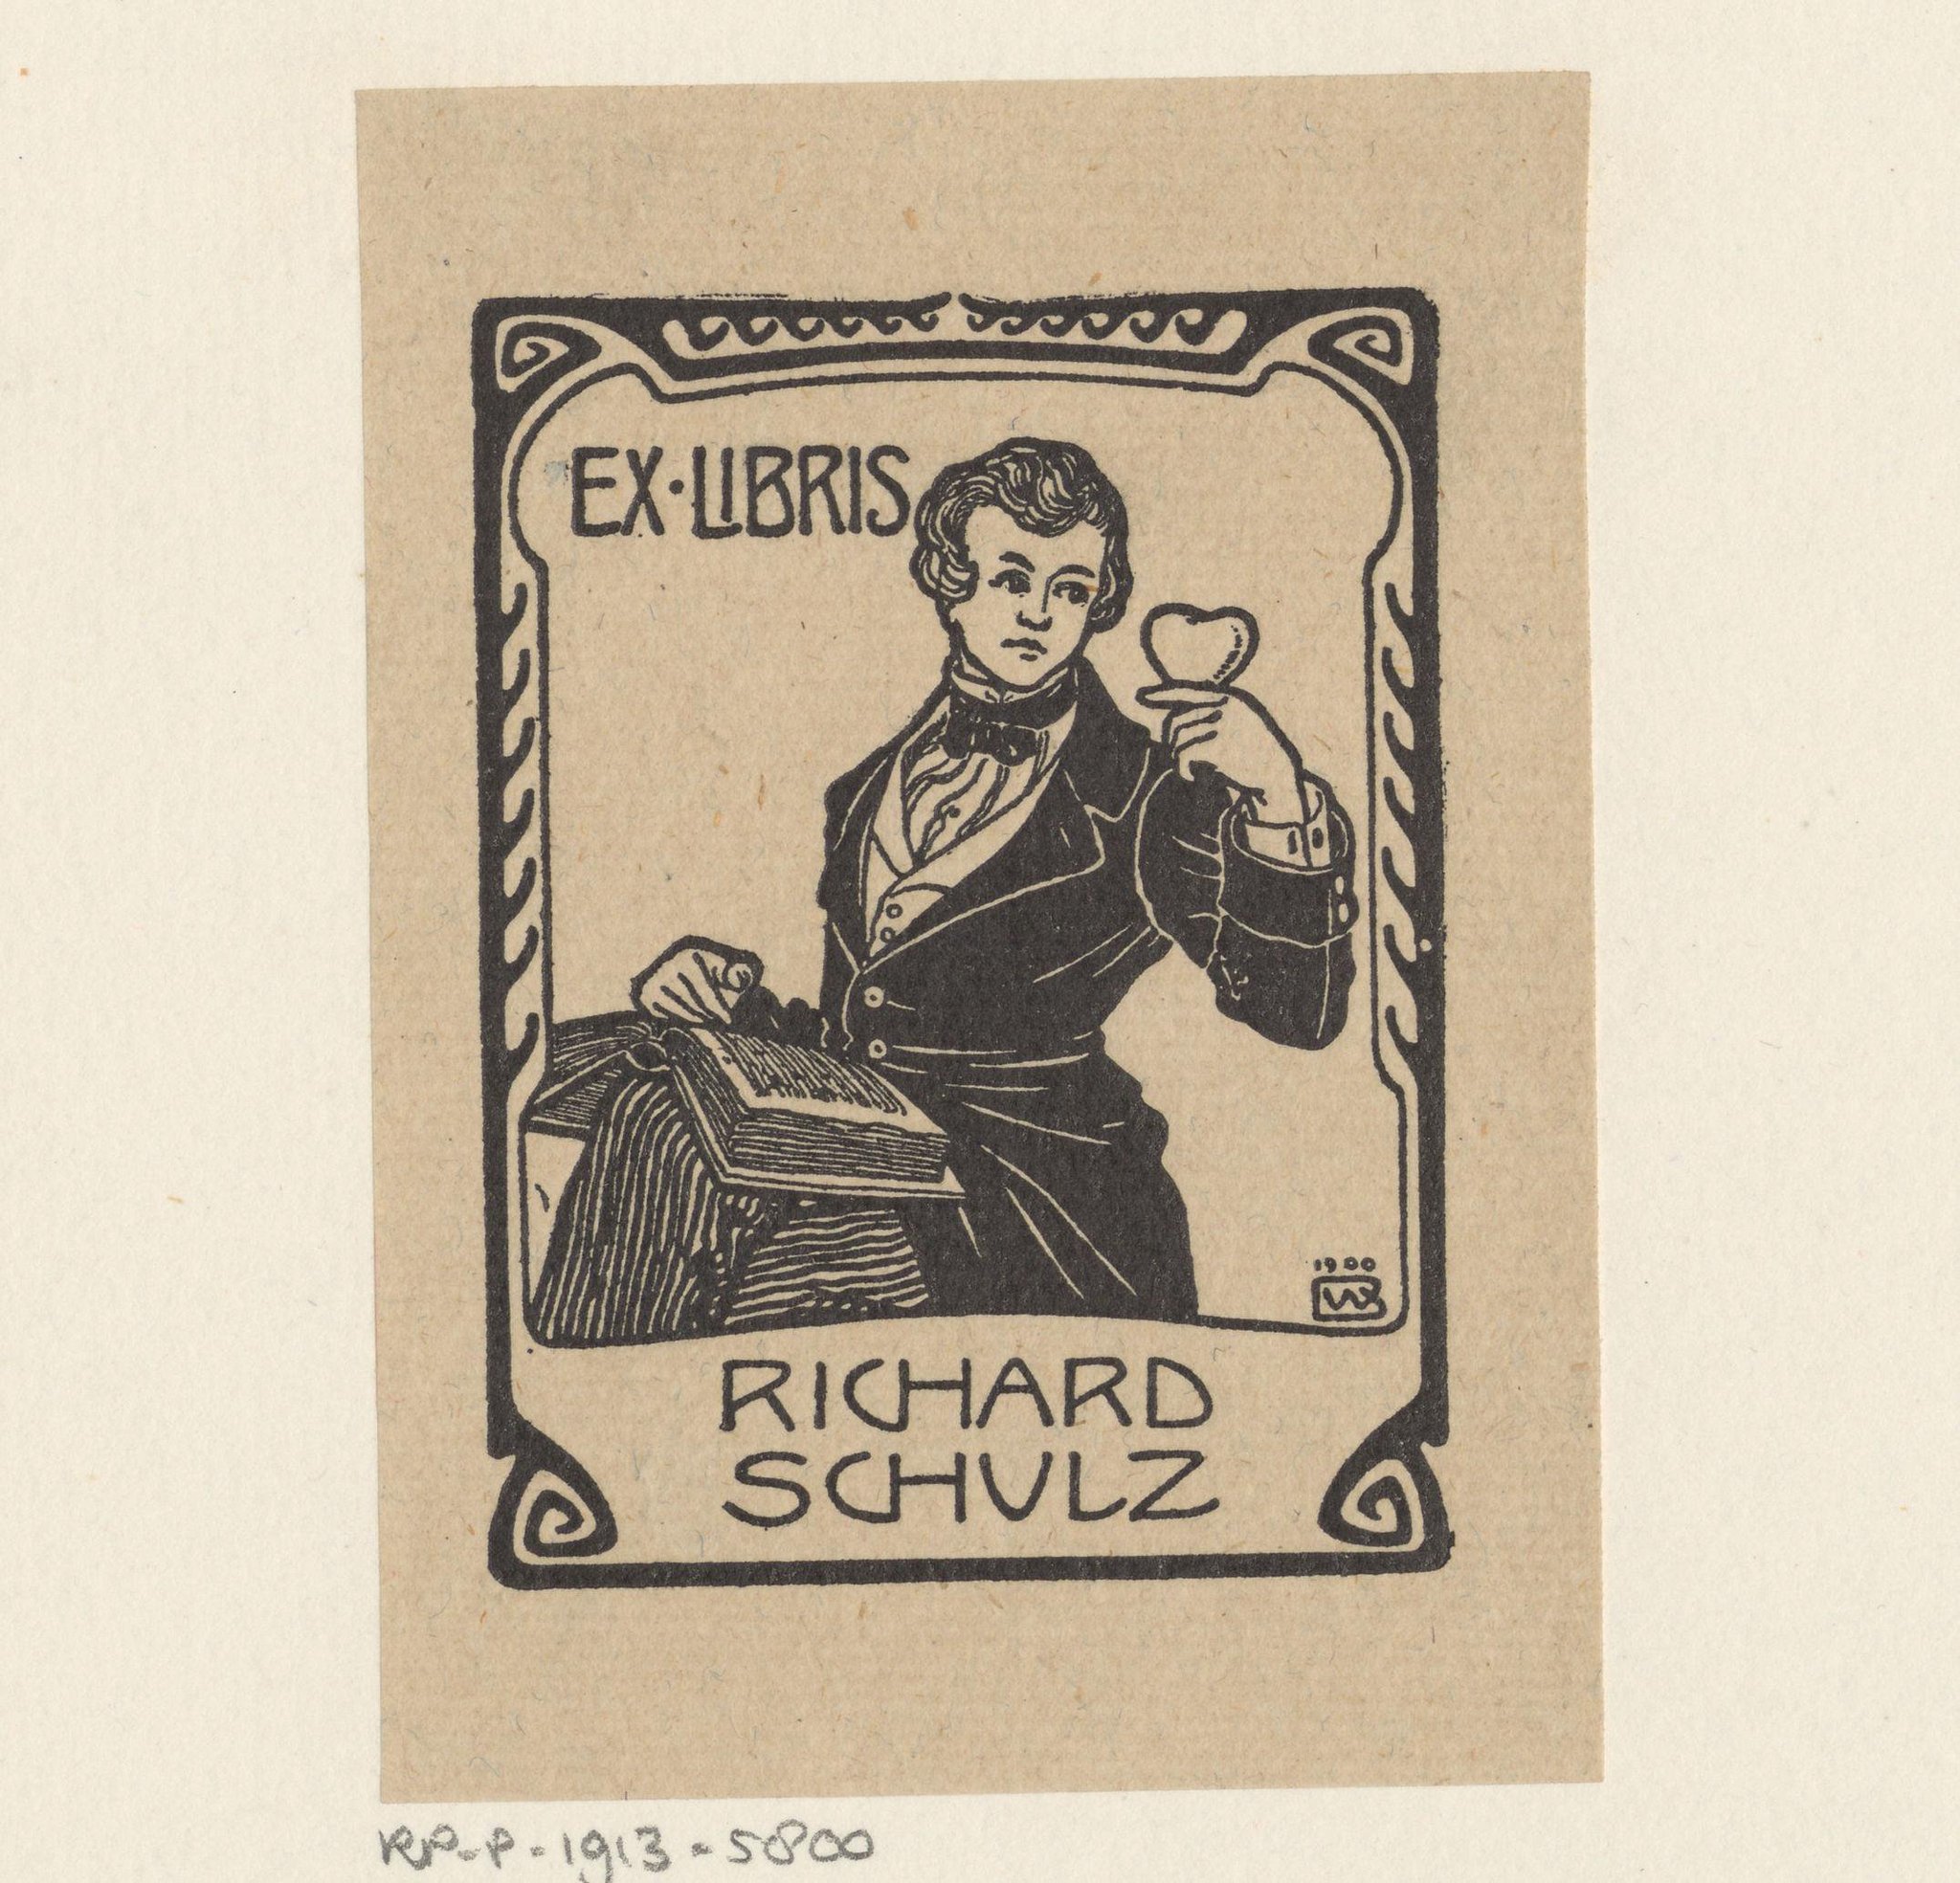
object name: bookplate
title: Ex libris van Richard Schulz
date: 1900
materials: paper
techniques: printing block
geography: germany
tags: sitting figure, youth, adolescent, historical costume, book, heart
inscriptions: collector's mark: Lugt 2760, collector's mark: Lugt 2233